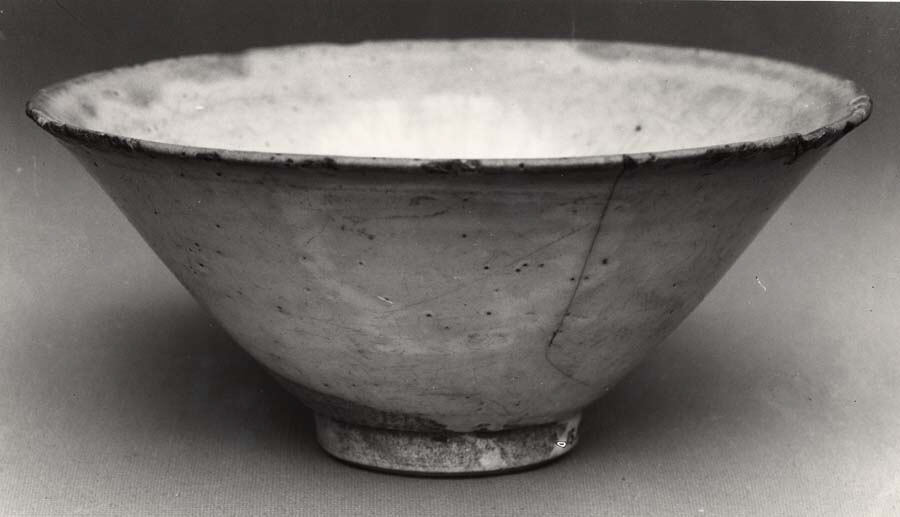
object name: bowl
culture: korean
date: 918-1392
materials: pottery